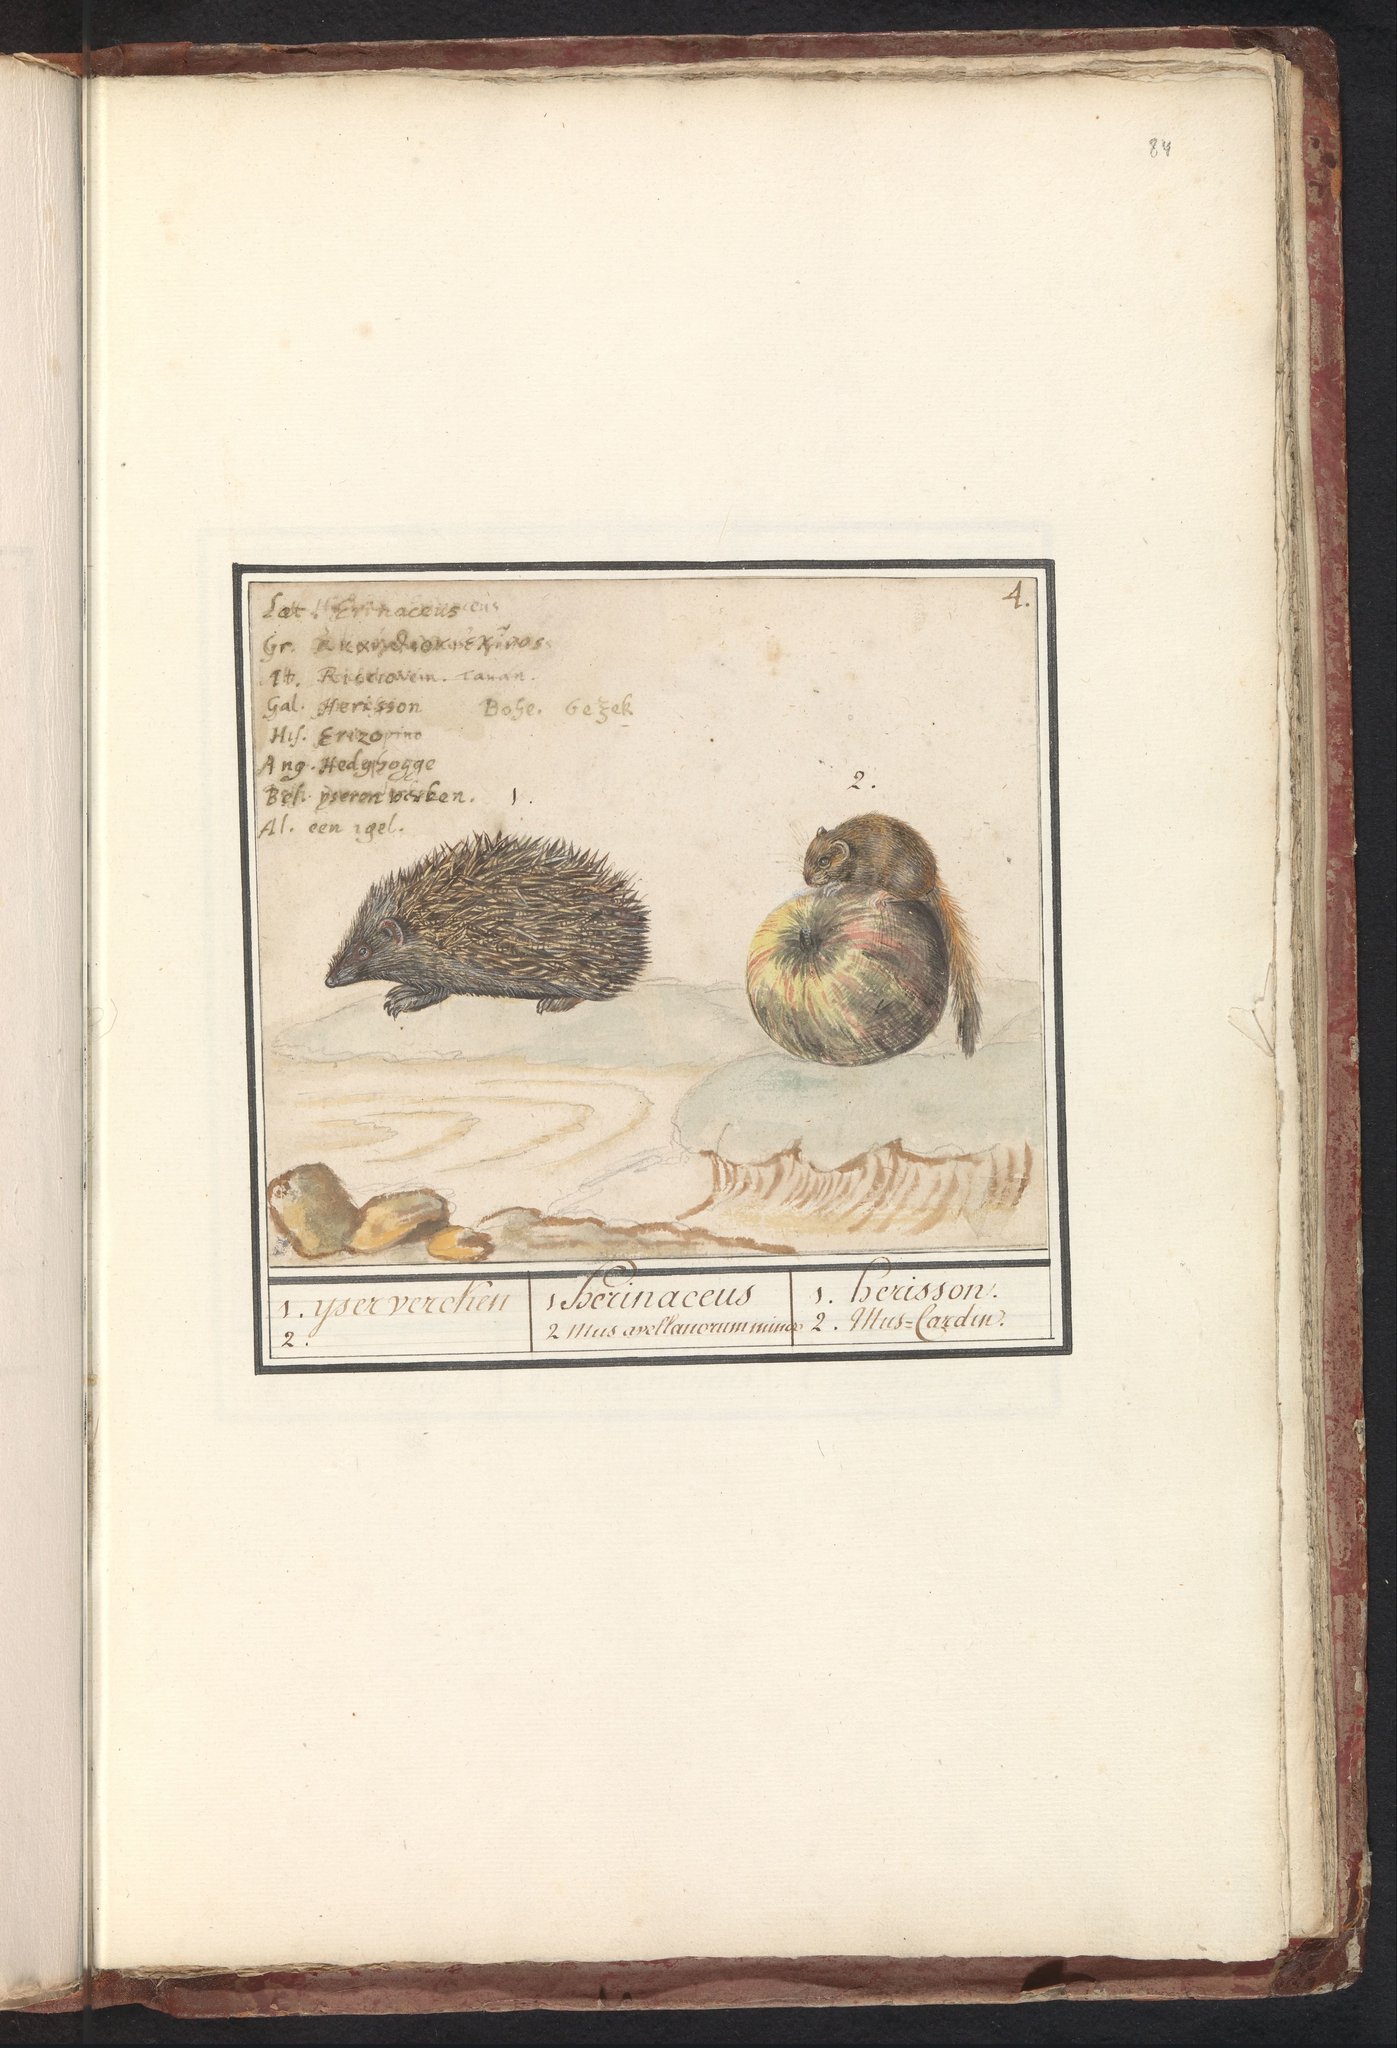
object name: drawing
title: Hedgehog (Erinaceus europaeus) and dormouse (Muscardinus avellanarius)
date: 1596-1610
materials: paint, ink, paper, pencil, watercolor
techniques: brush, pen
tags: rodents: hazel dormouse, other mammals: hedgehog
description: In the early 19th century, the mayor of Bruges, Van Huerne, had the Historia Naturalis rebound. The drawings were pasted onto pages provided with frames containing the Dutch, Latin and French names of each creature. Additionally, he commissioned artists to enhance the drawings by adding surrounding details and backgrounds. This hedgehog and dormouse have been frequenting a dune landscape ever since.